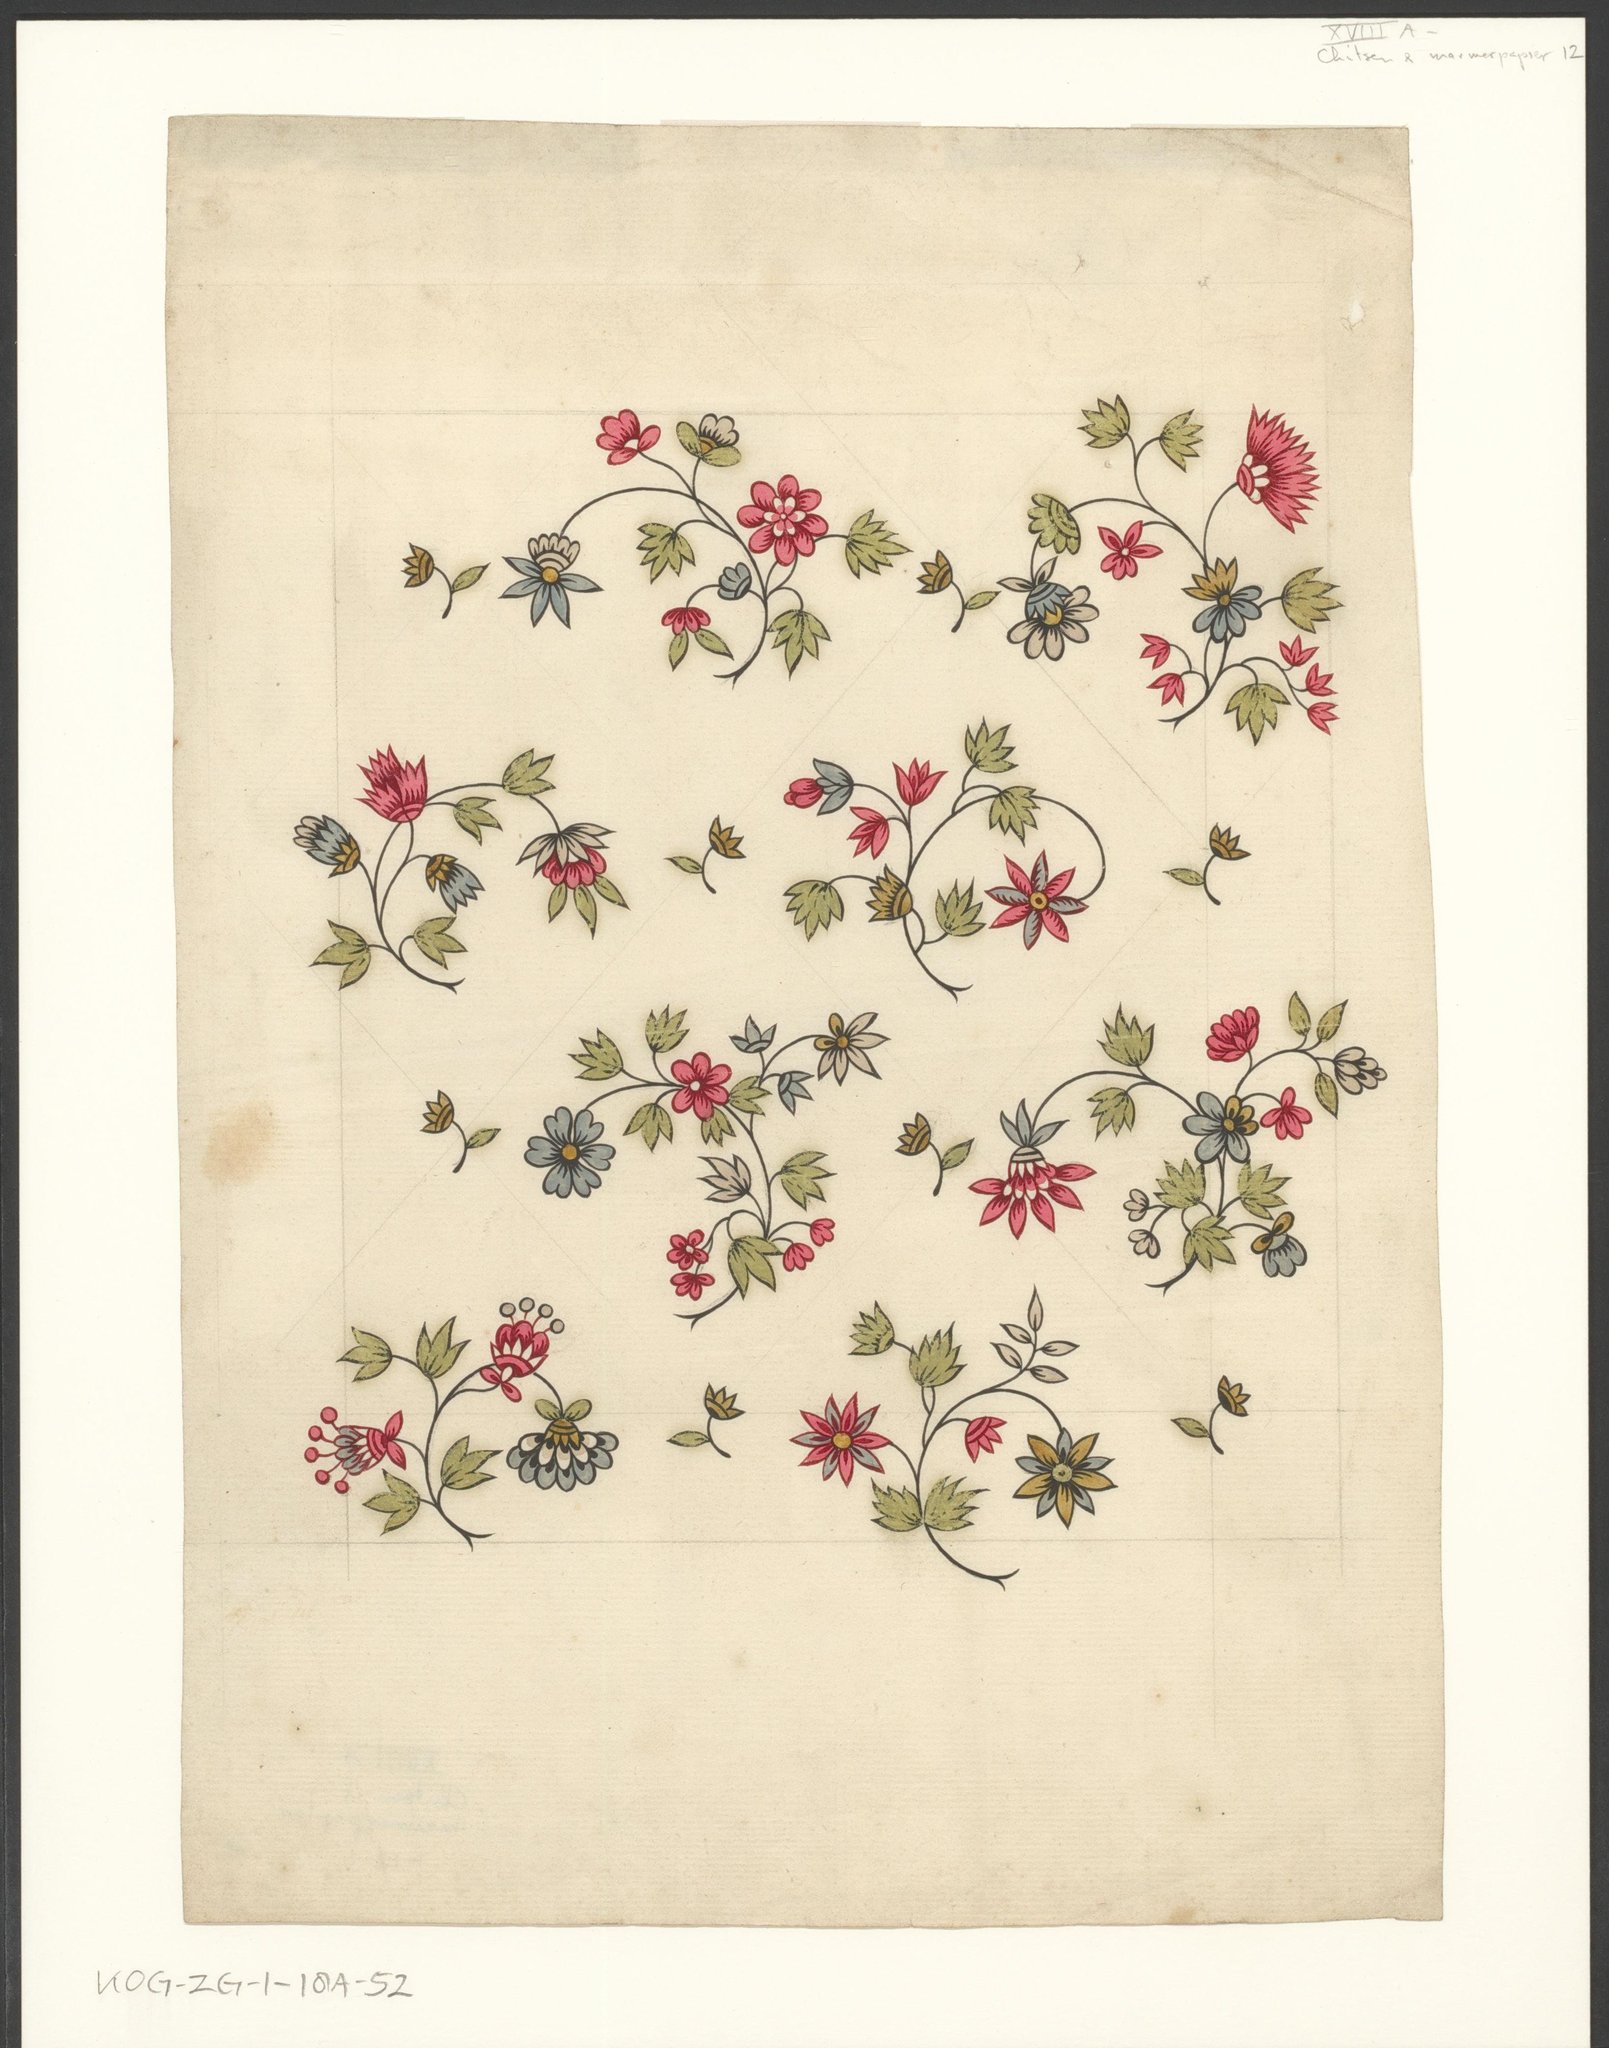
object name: drawing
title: Ontwerp voor een sits met bloemen en takken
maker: Anonymous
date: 1750-1799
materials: chalk, paper, pencil, watercolor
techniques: brush, pen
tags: flowers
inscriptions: stamp, collector's mark: Lugt 1641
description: Onderwerpsrubrieken binnen de Atlas Zeden en Gewoonten: Schoone kunsten, Sitsen en marmerpapier.